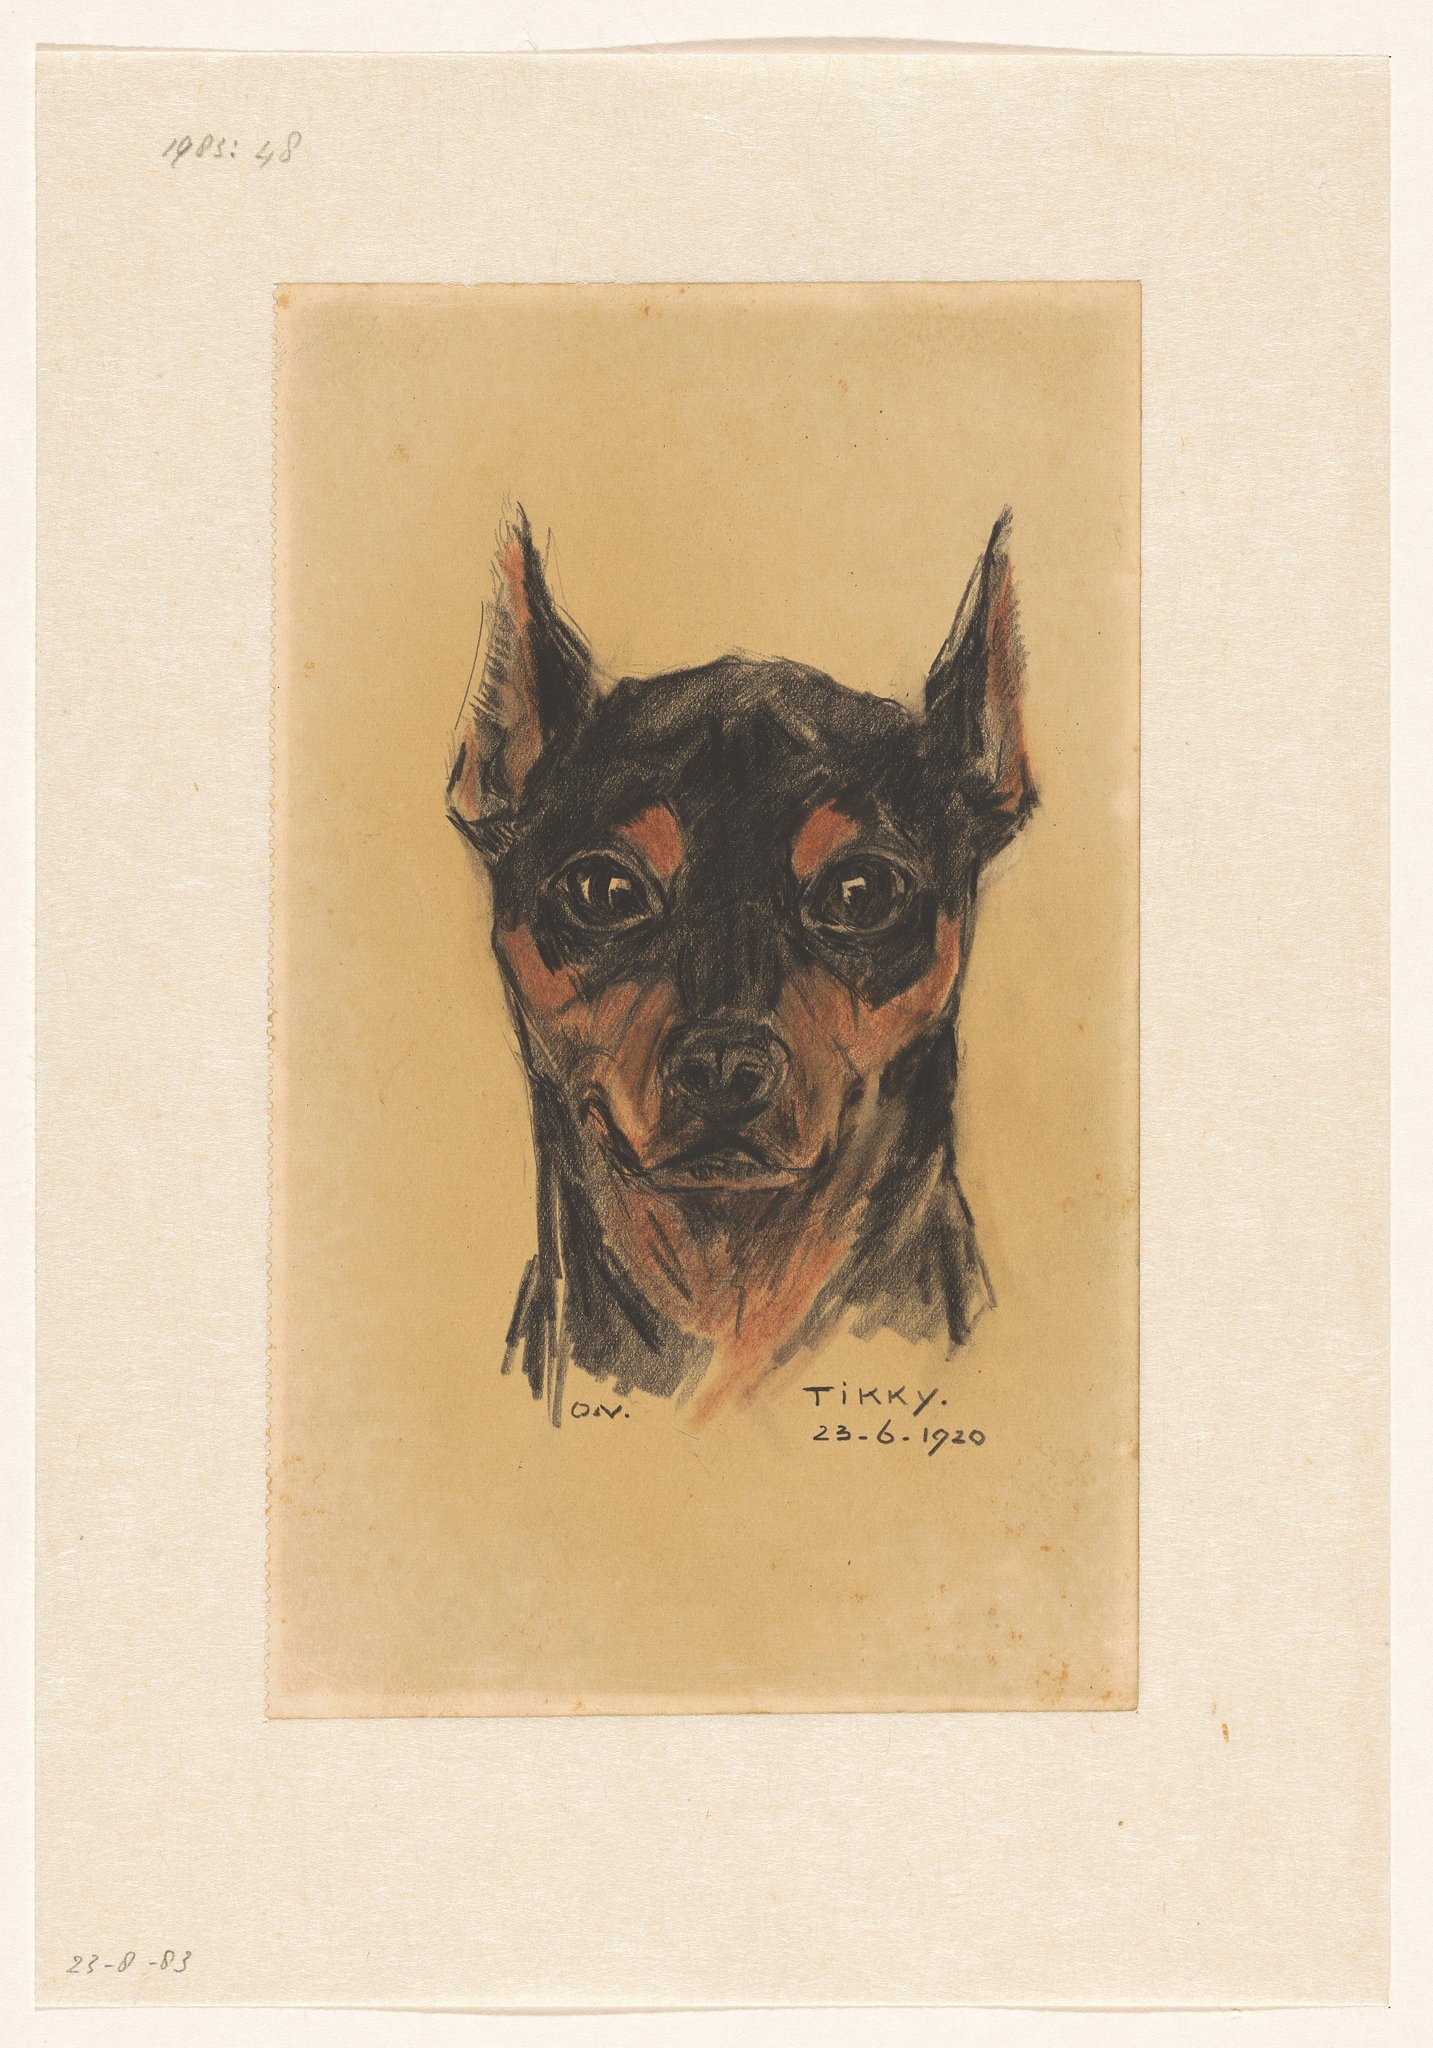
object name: drawing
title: Tikky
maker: otto verhagen (i)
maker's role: draughtsman, print maker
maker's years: 1885-1951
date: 1920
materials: chalk, paper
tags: dog (doberman)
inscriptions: collector's mark: Lugt 2228